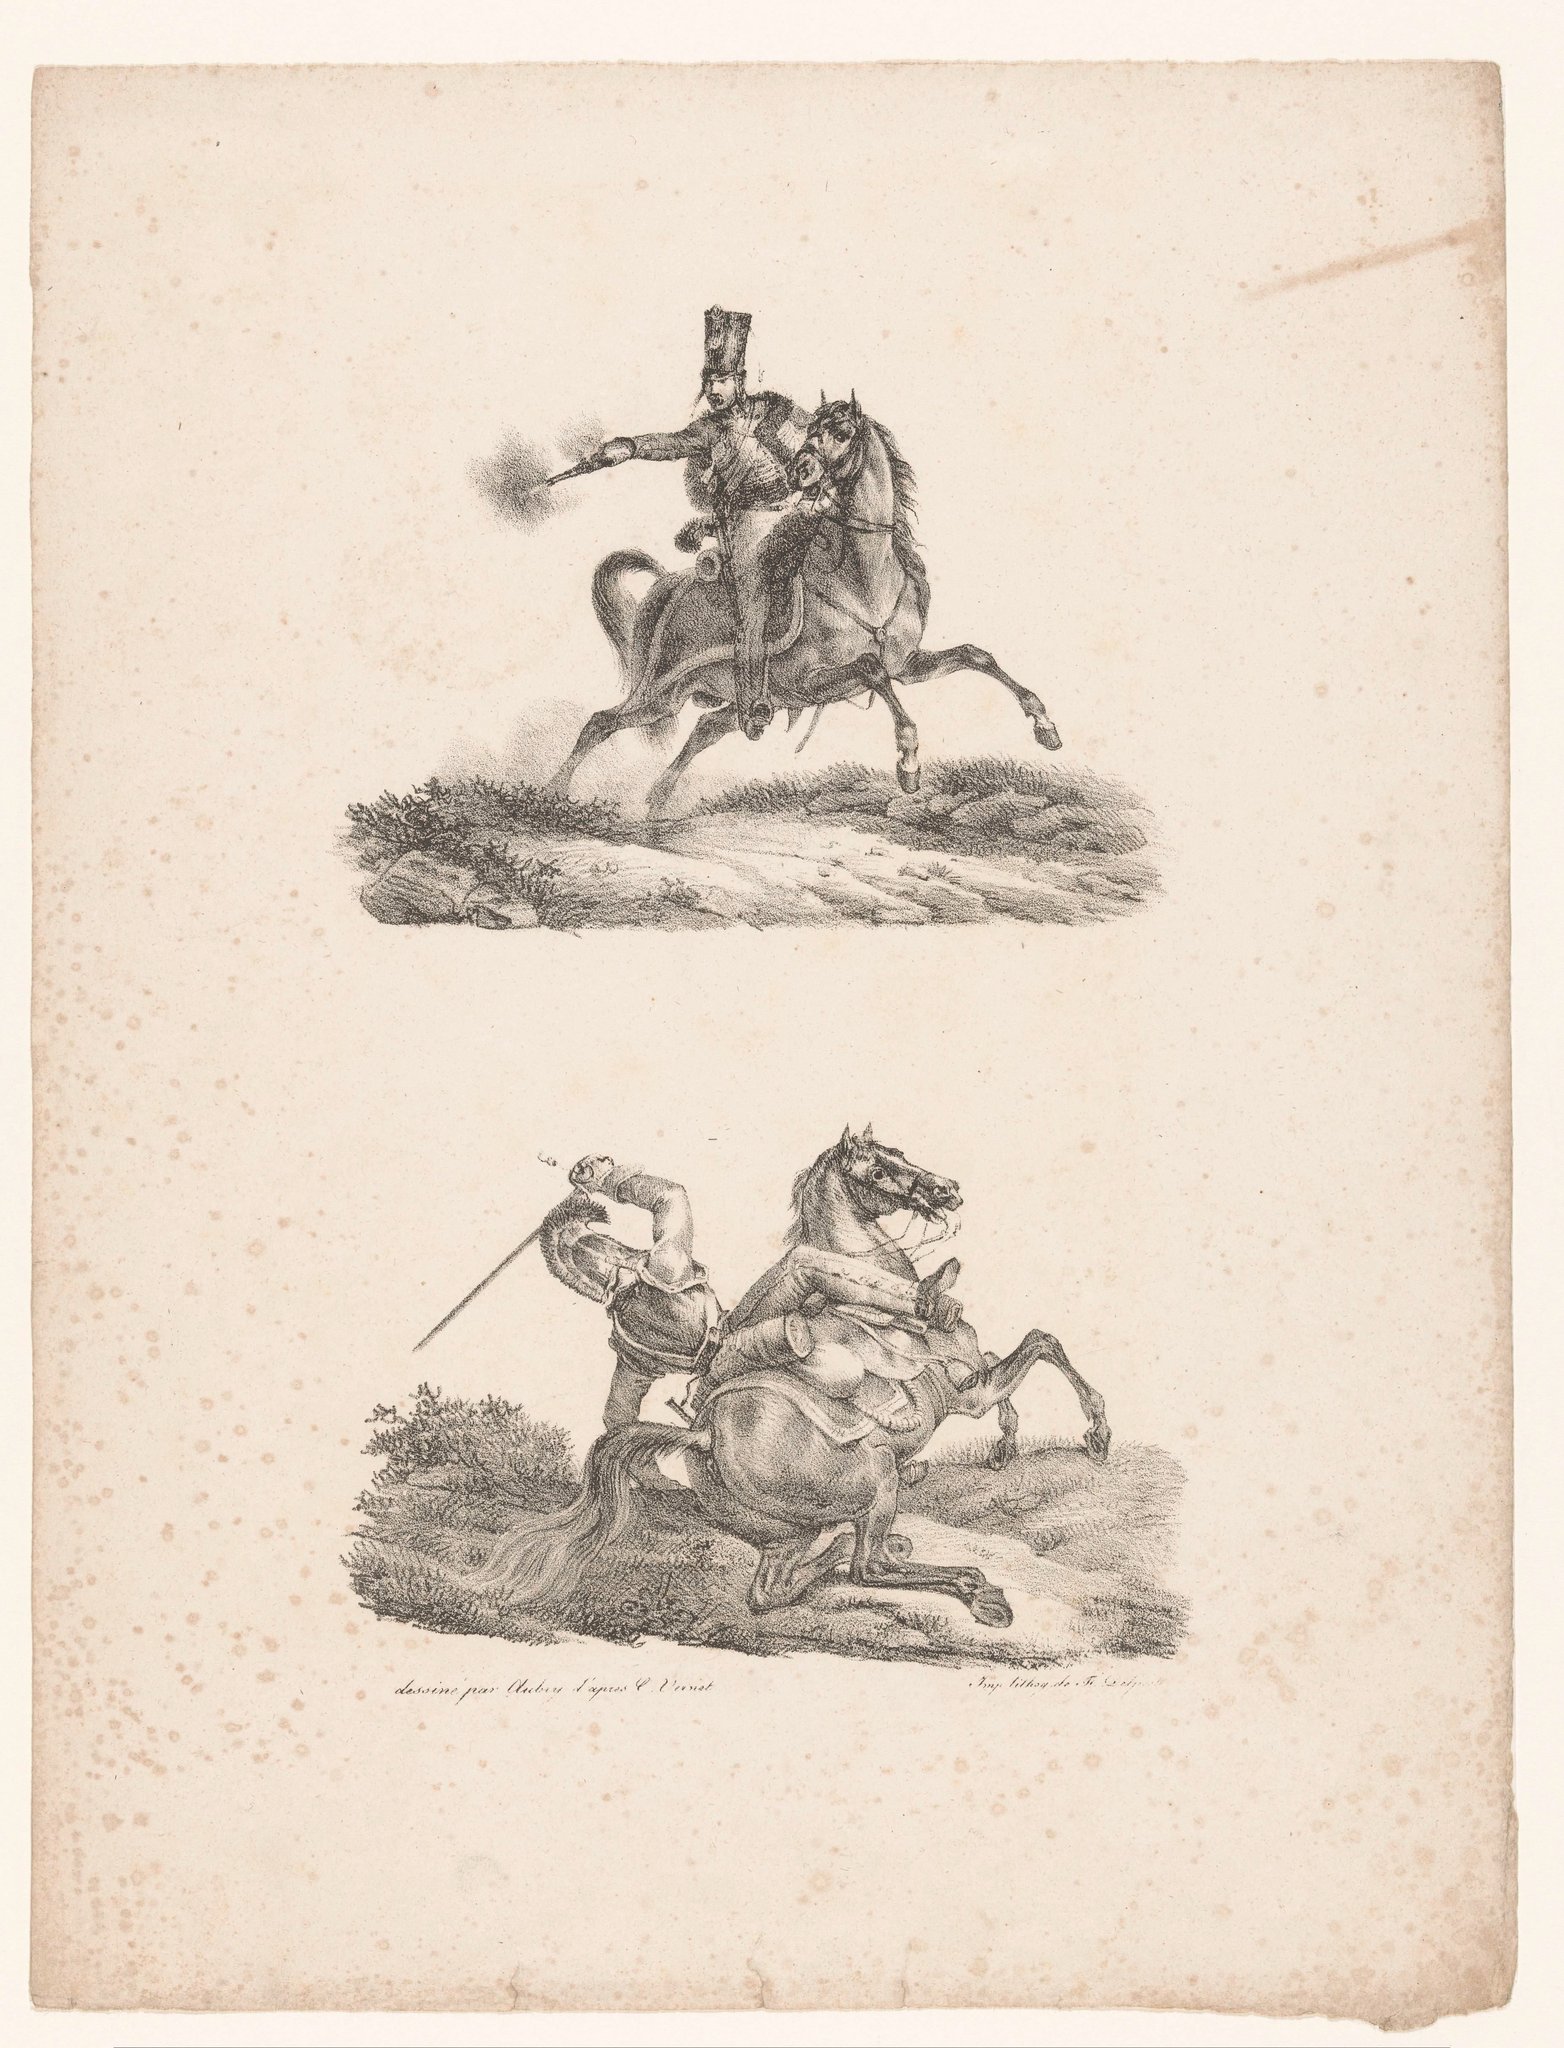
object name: print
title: Soldaat te paard vuurt een schot af en soldaat valt van zijn paard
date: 1823-1824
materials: paper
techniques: lithograph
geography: paris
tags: riding a horse, ass, or mule; rider, horseman, private soldier (+ cavalry, horsemen), accident with horse (or kindred animal)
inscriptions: collector's mark: Lugt 2228a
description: Twee voorstellingen met een soldaat die een schot vuurt vanaf zijn paard en een soldaat die met een getrokken zwaard van zijn paard afvalt.